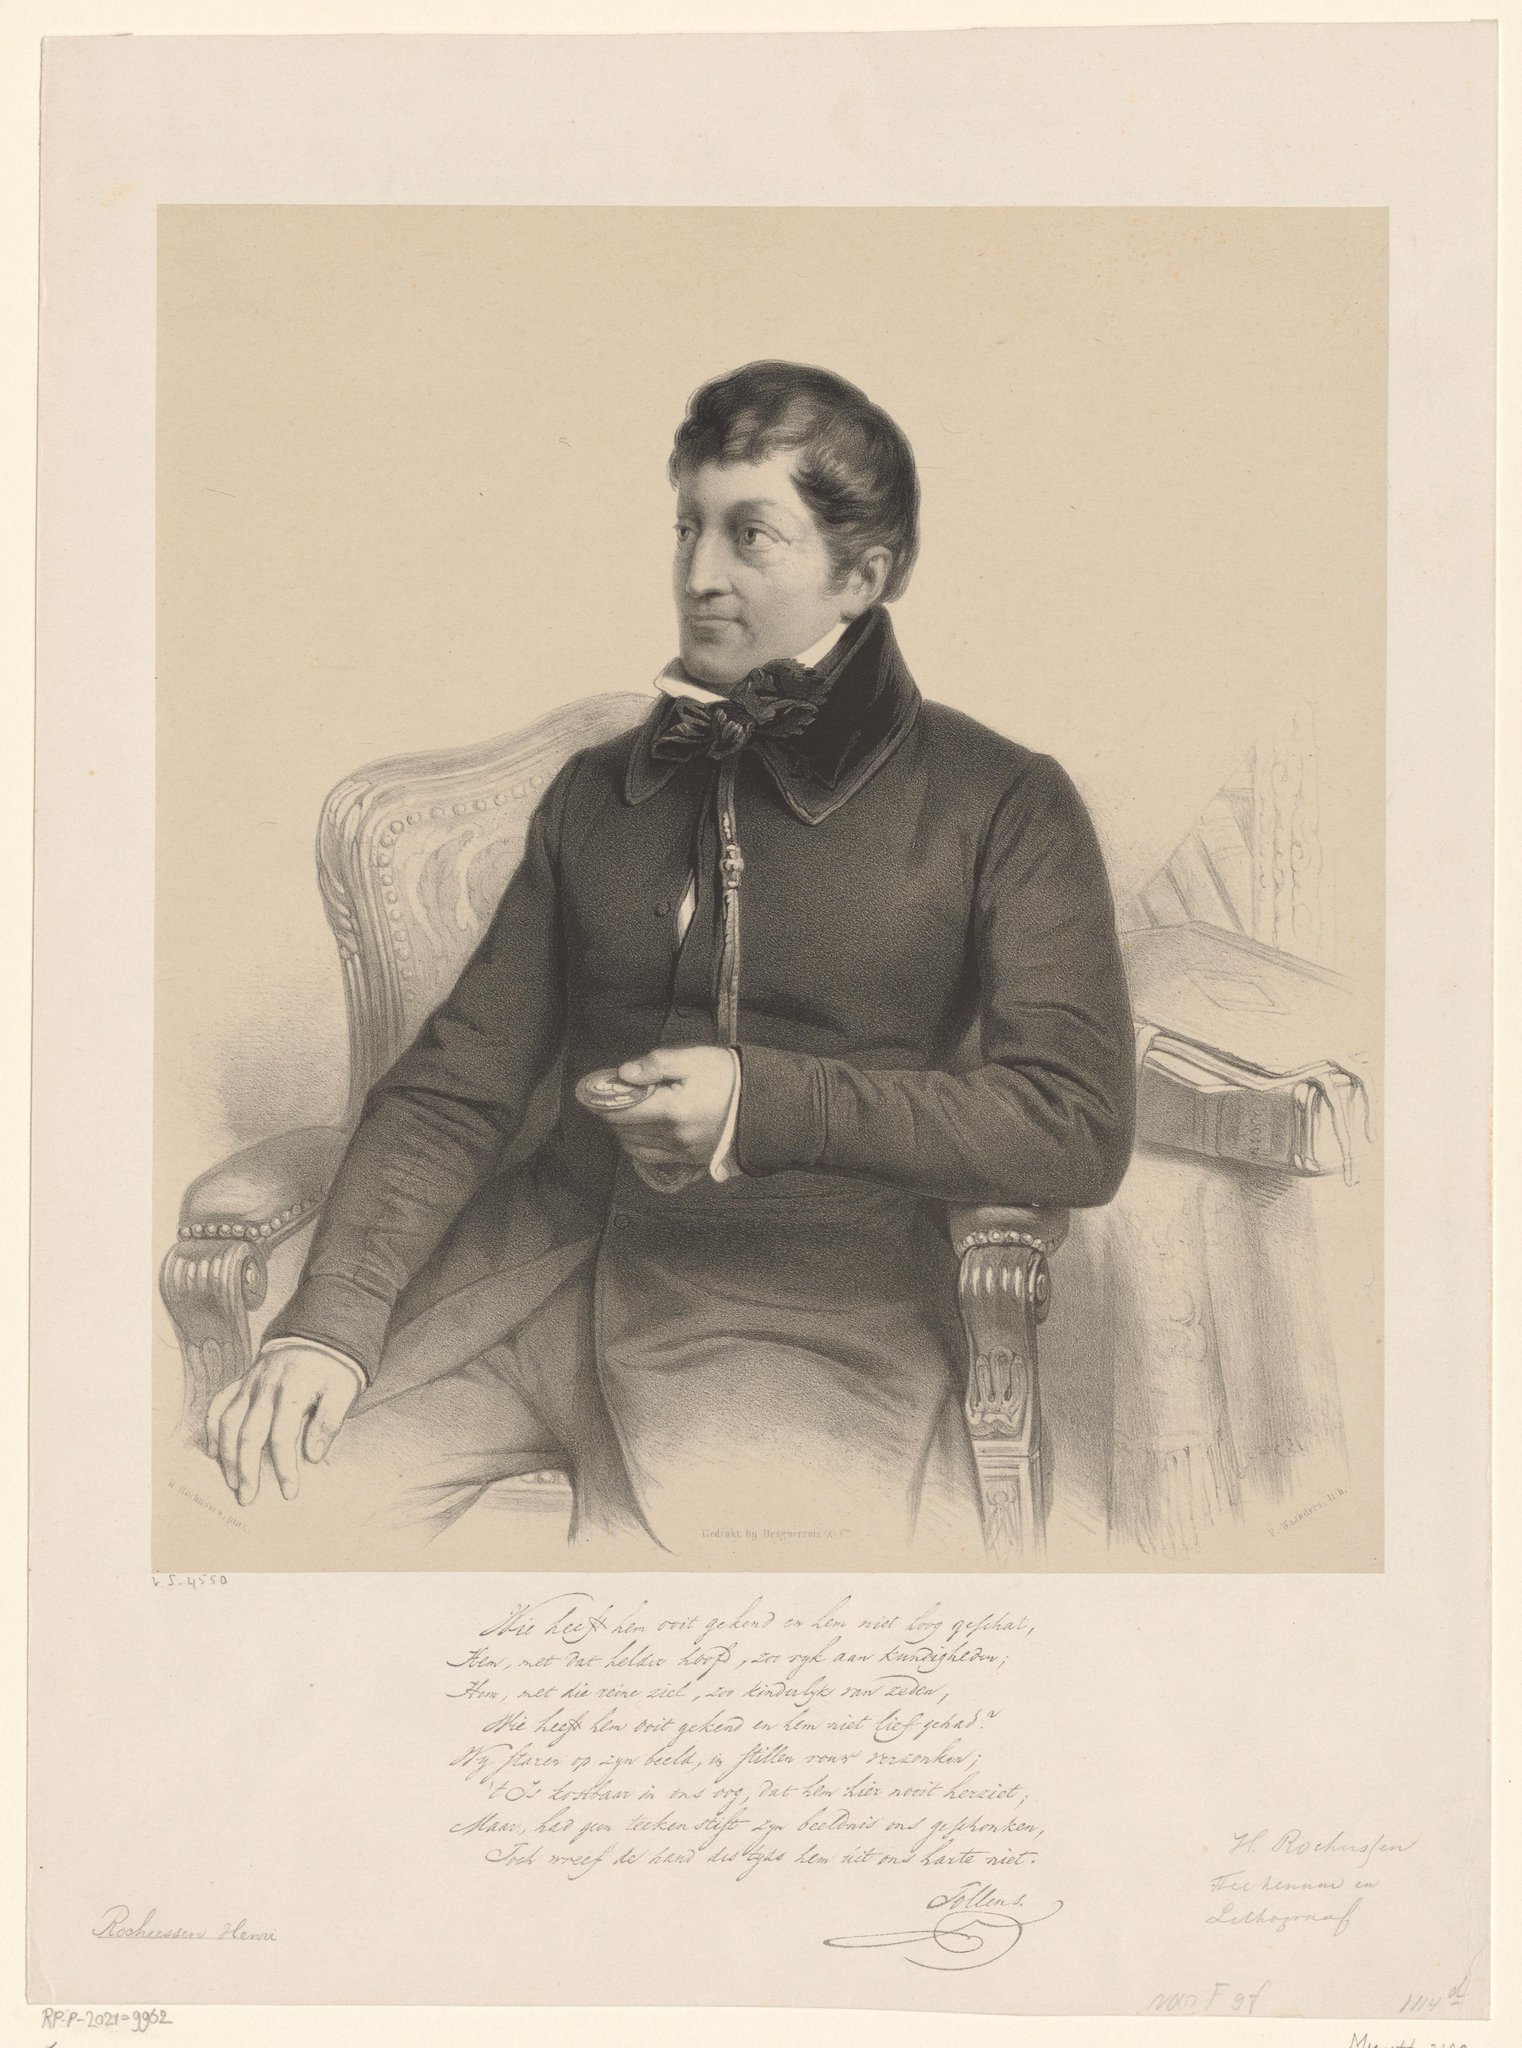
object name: print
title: Portret van Henri Rochussen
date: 1827-1900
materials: paper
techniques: lithograph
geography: amsterdam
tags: draughtsman, henri rochussen, sitting figure, historical persons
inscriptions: collector's mark: Lugt 2166, collector's mark: Lugt 2760